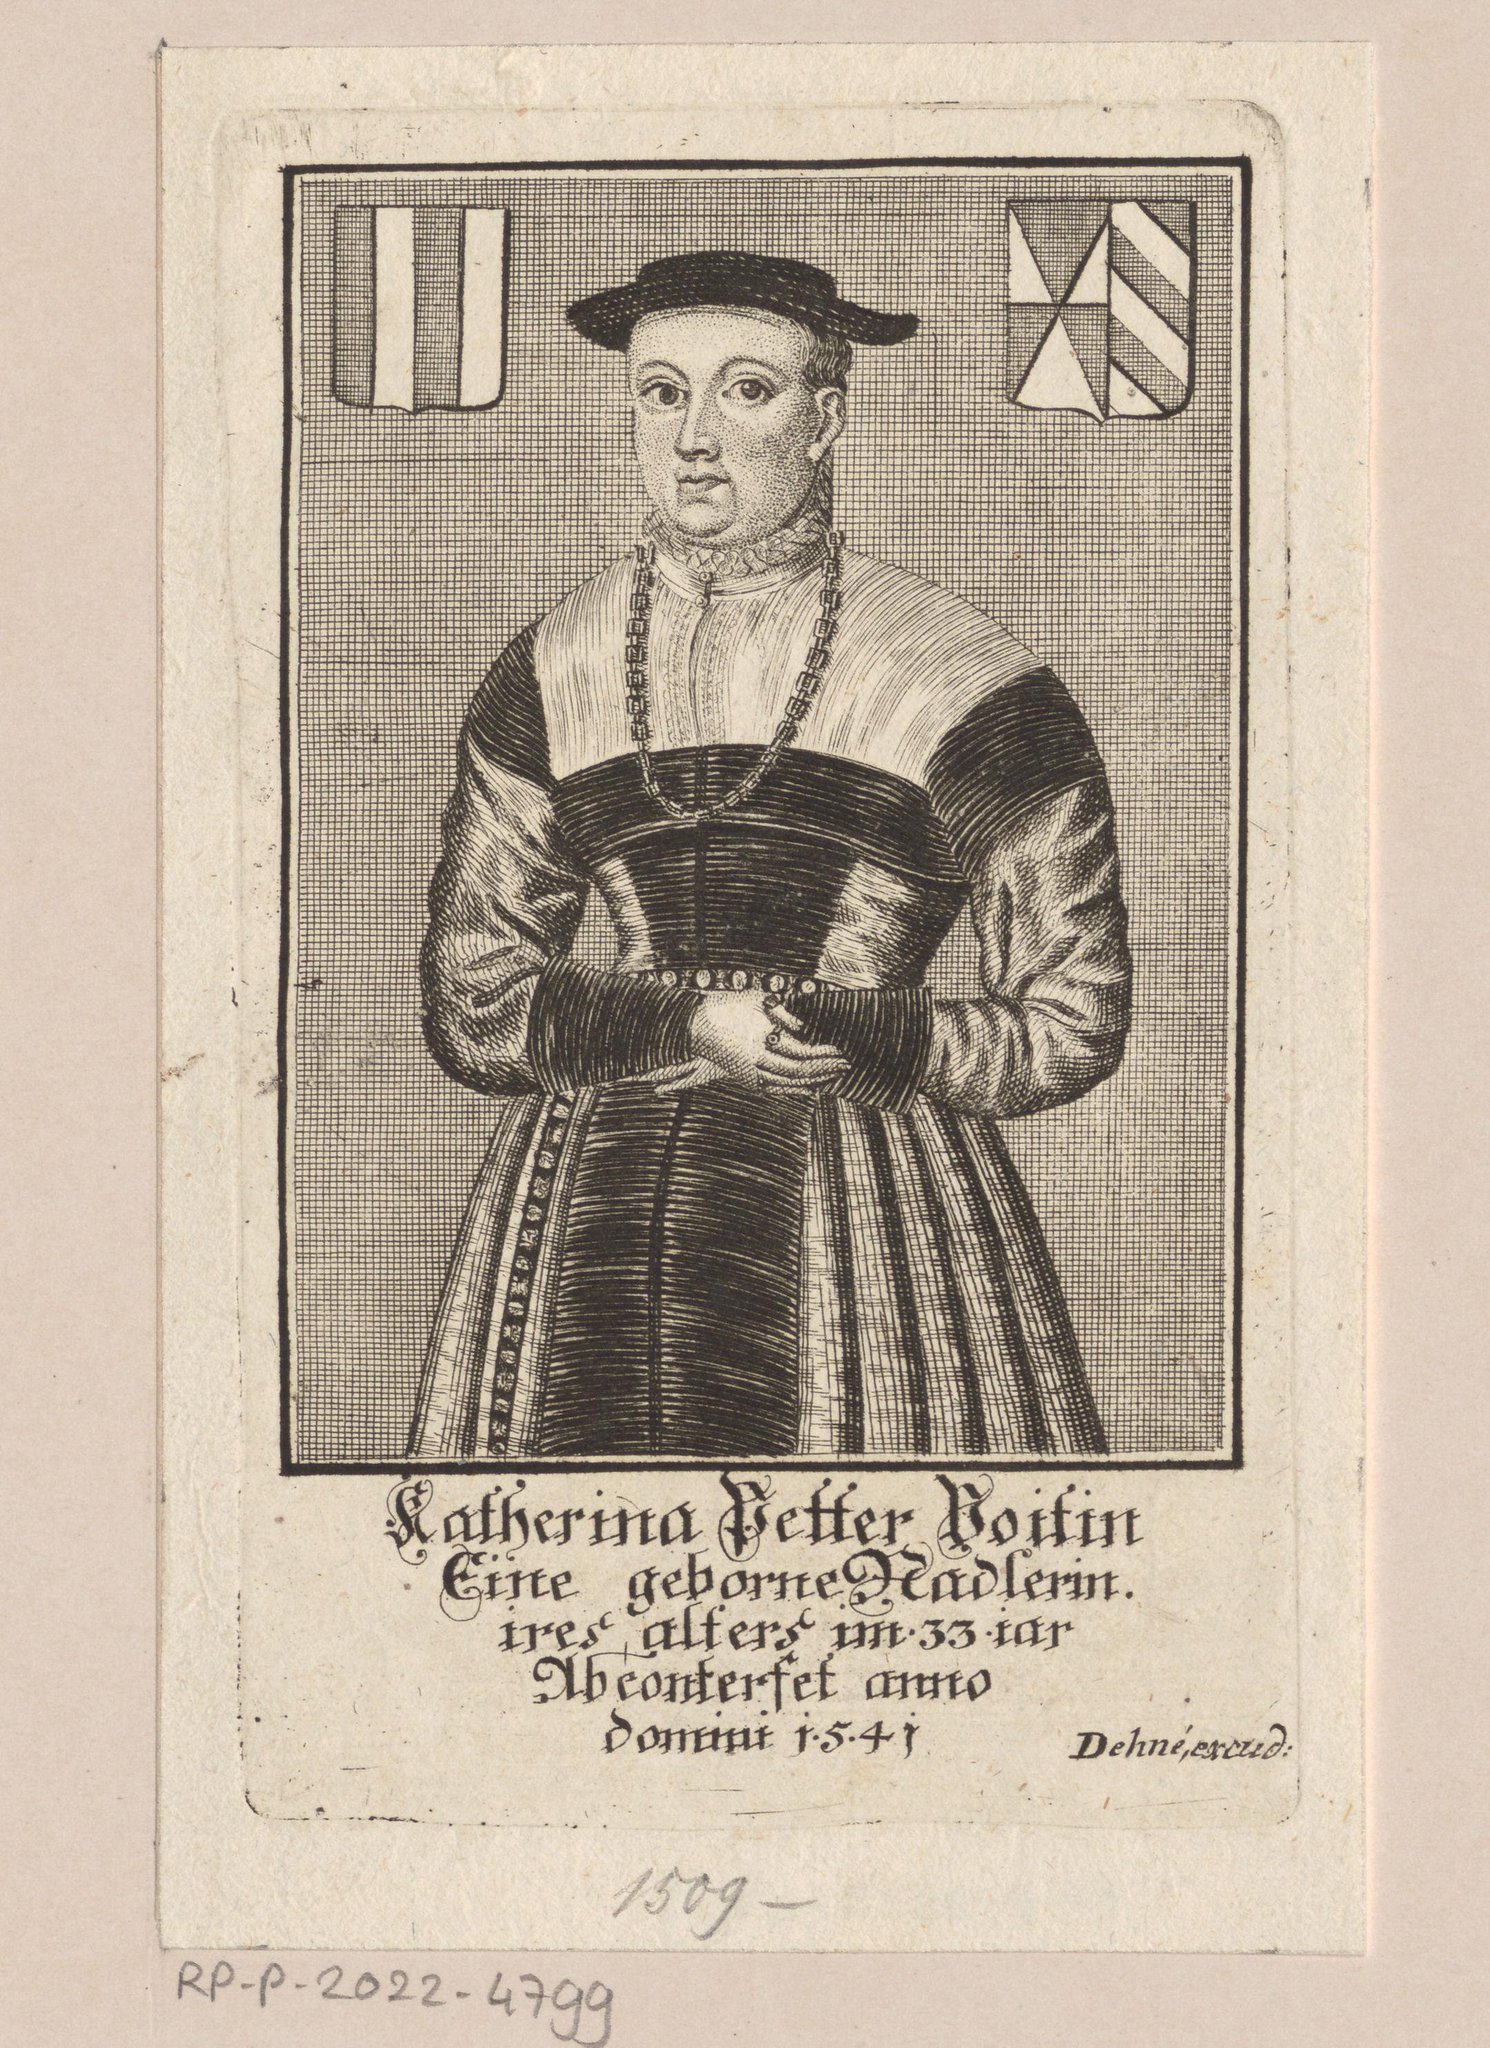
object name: print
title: Portret van Katharina Voit von Wendelstein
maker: johann christoph dehne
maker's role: print maker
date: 1714-1726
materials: paper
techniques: engraving, etching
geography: germany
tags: historical persons